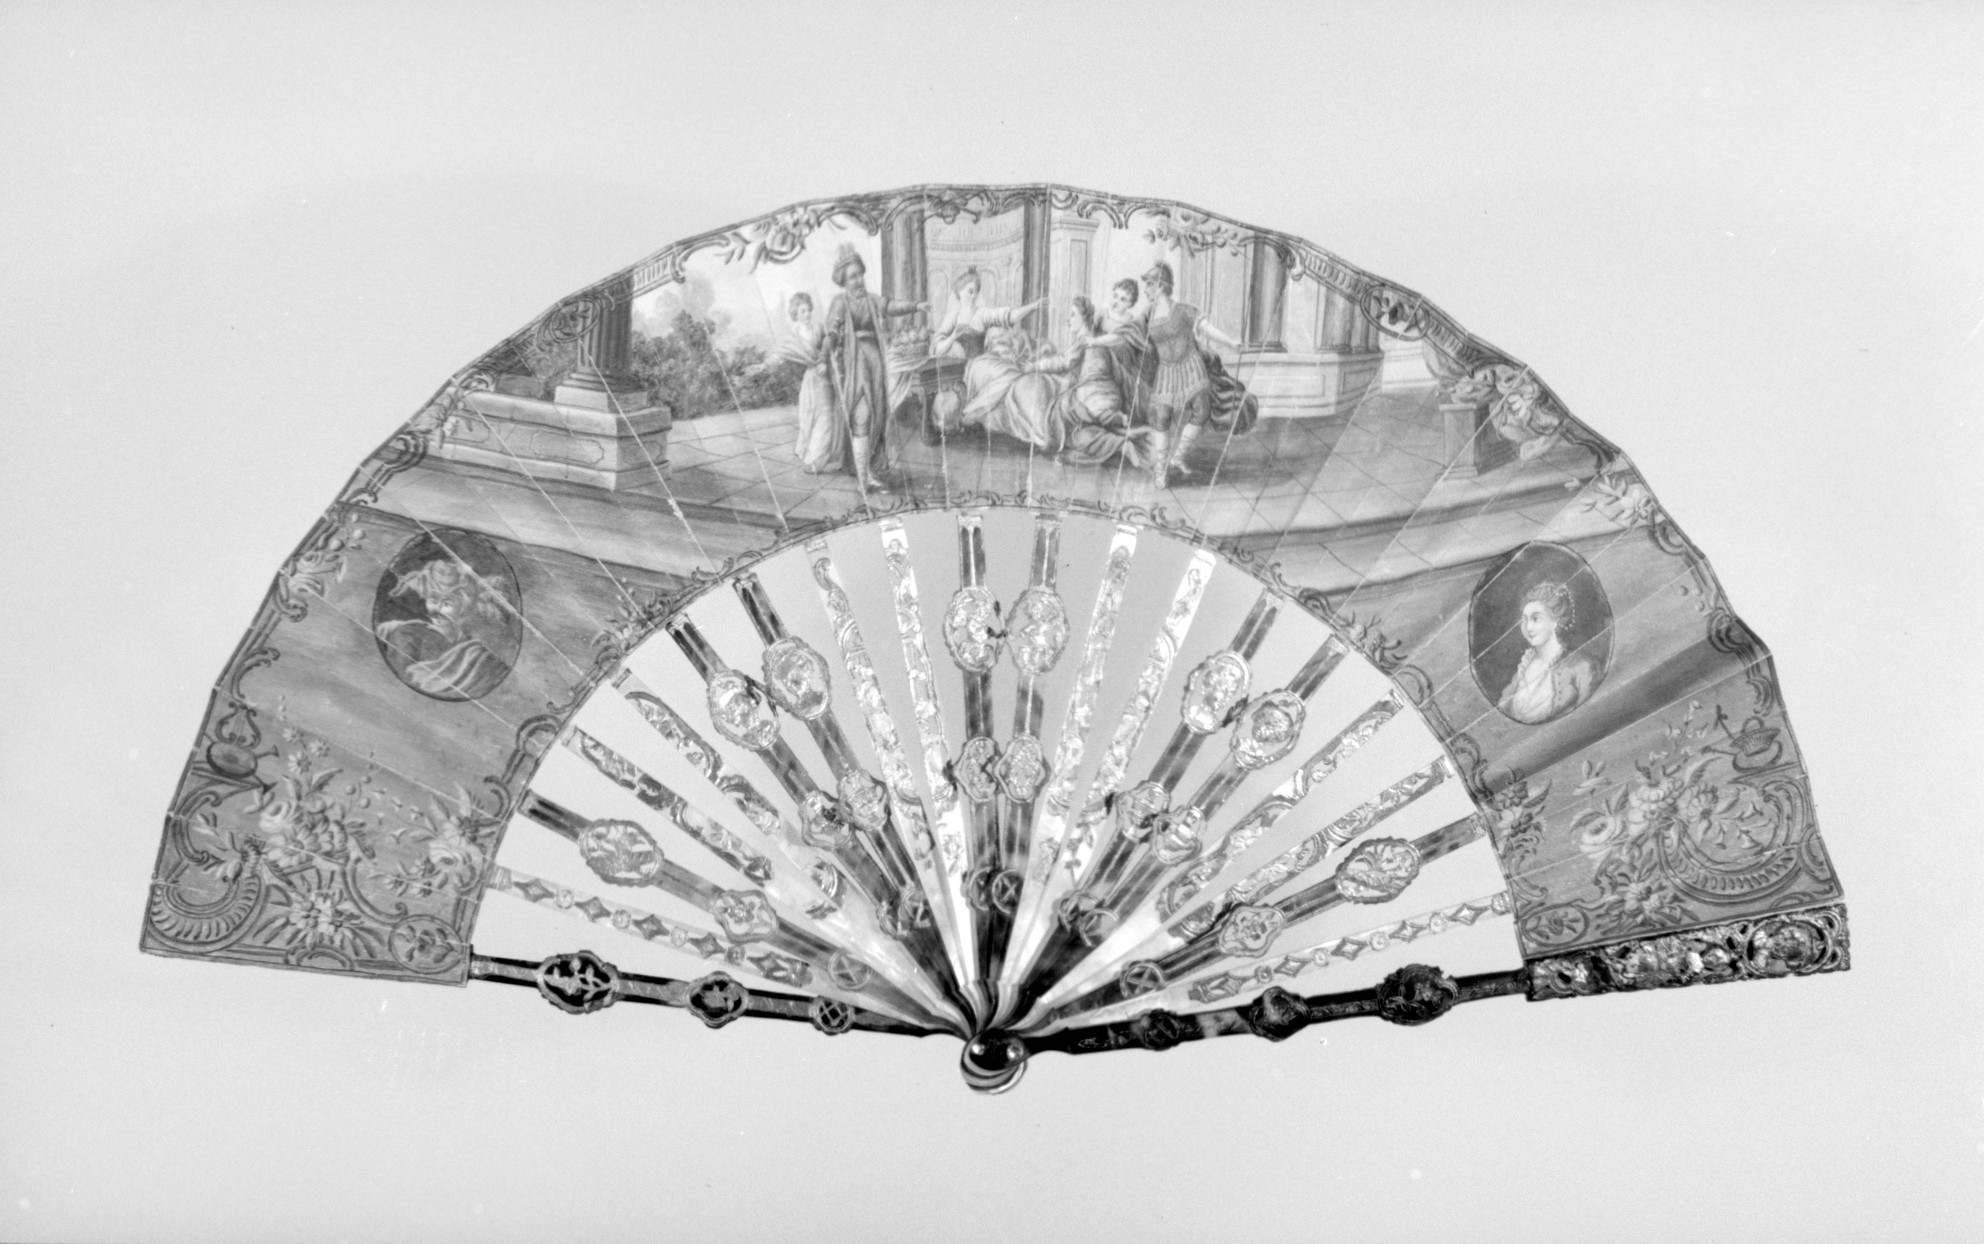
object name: fan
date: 1701-1800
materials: mother of pearl, paper, parchment, shell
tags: men,women